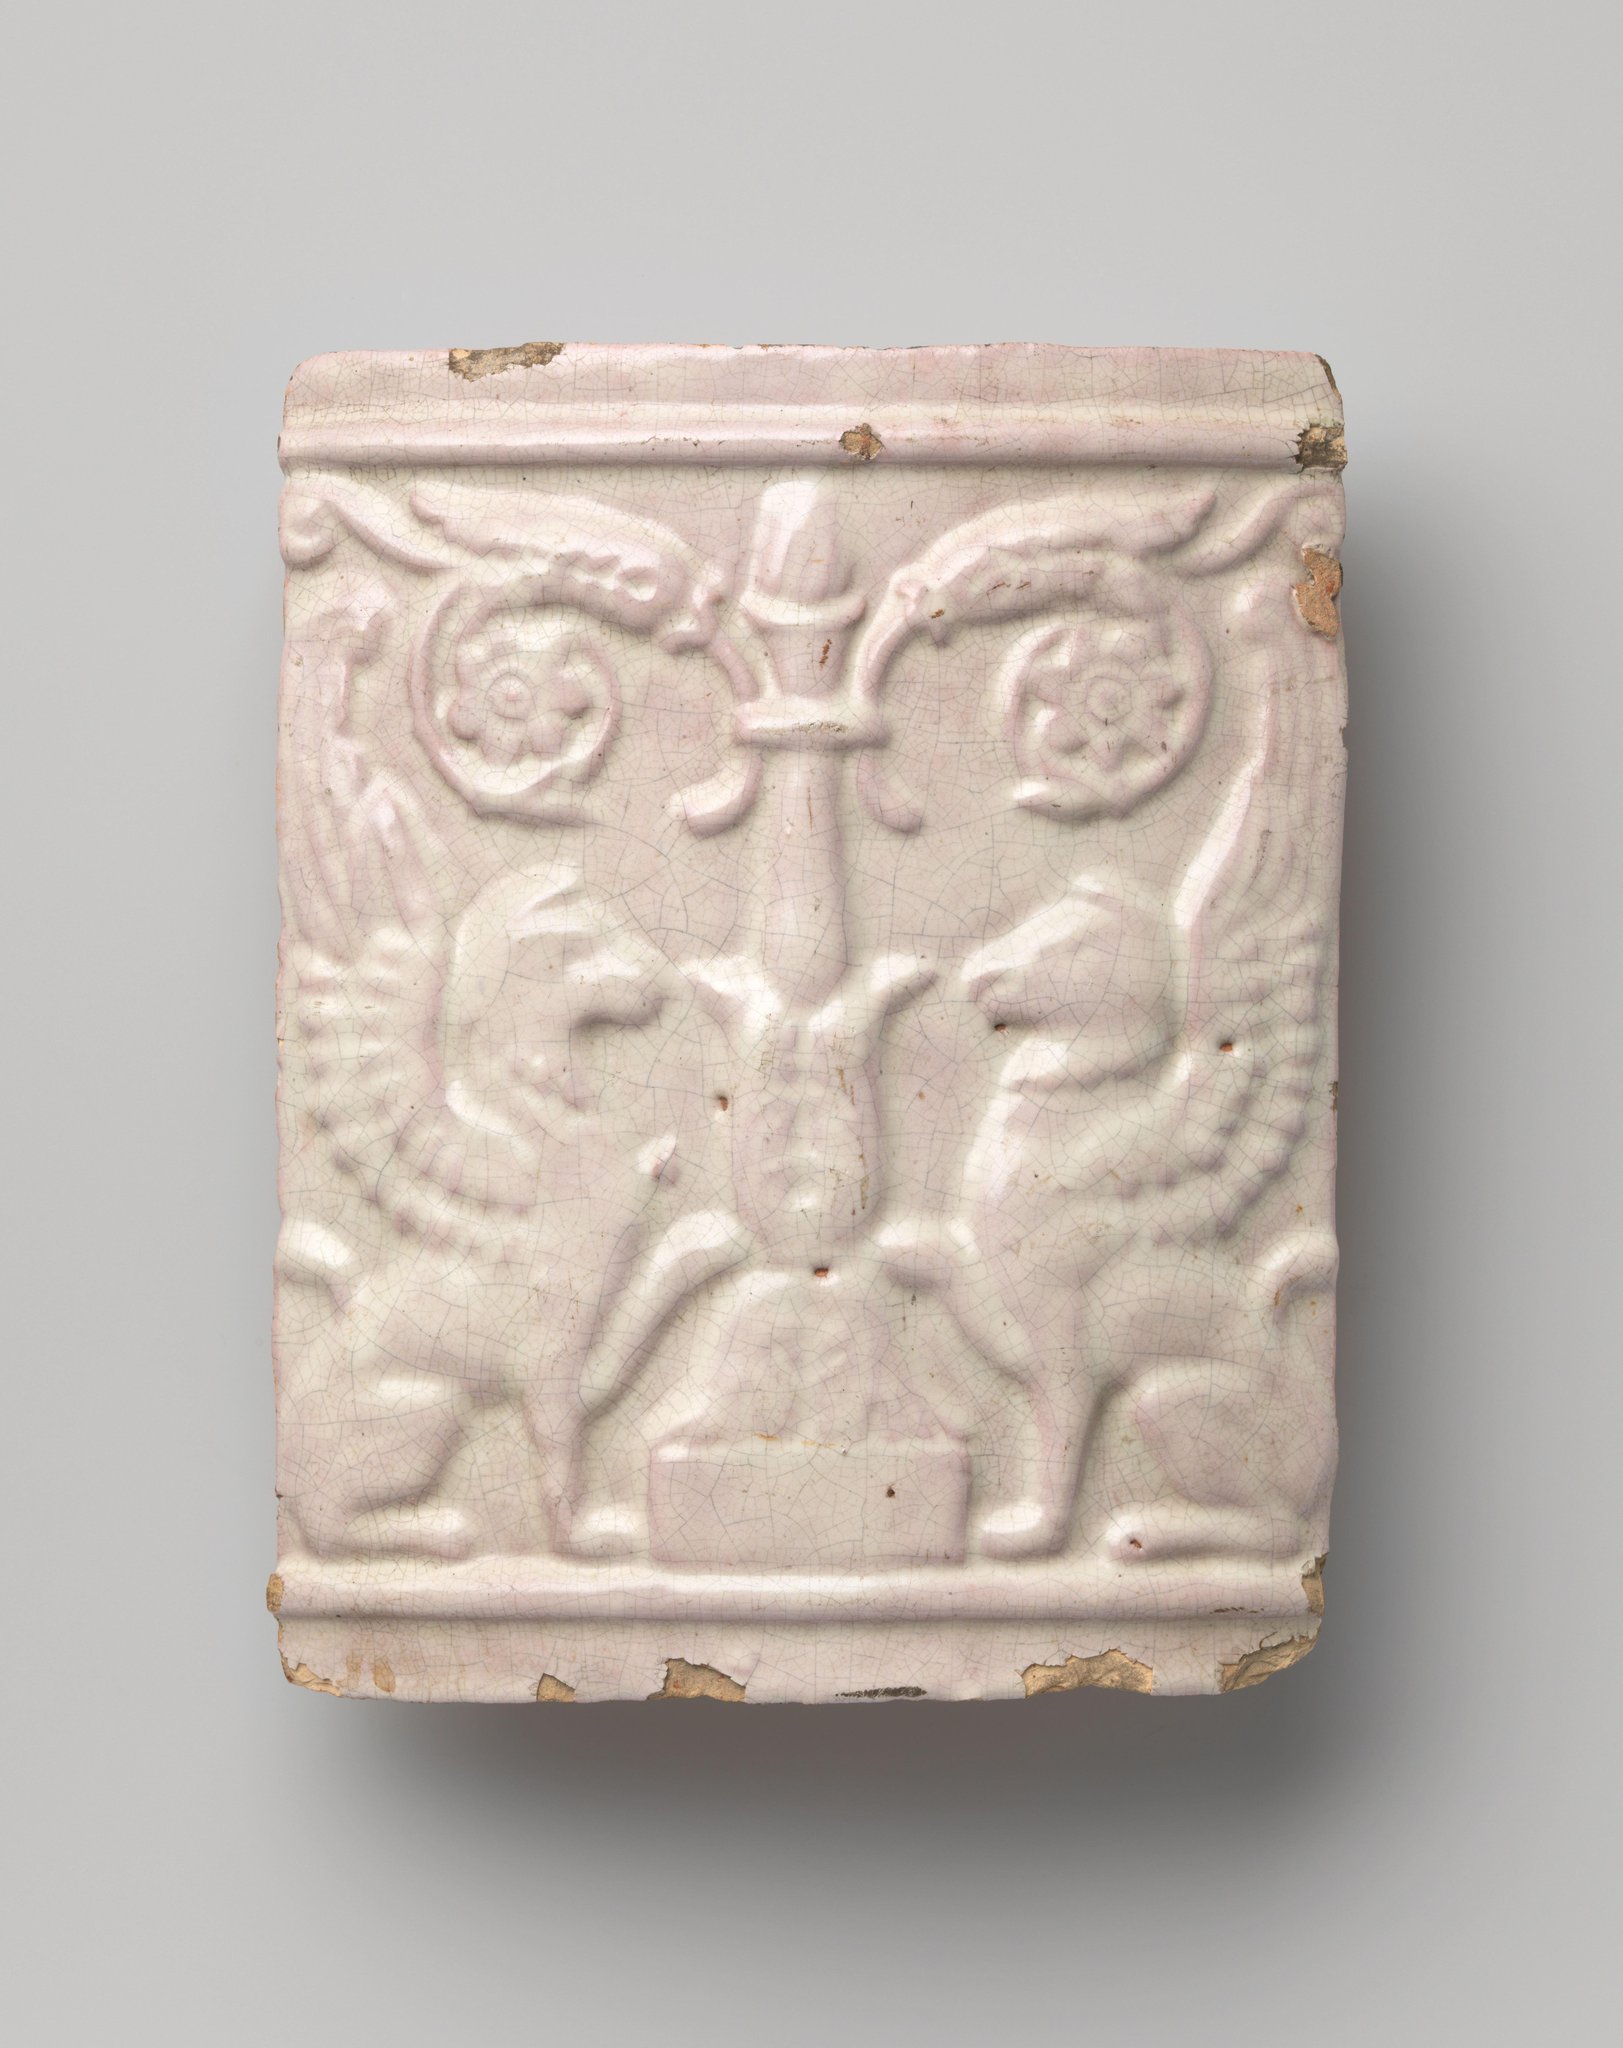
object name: kacheltegel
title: Kacheltegel versierd met griffioenen, kandelaber en bloemen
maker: Anonymous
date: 1850-1900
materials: earthenware, glaze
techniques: firing, relief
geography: zeist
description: Kacheltegel van rood aardewerk, bedekt met witte tinglazuur en versierd met griffioenen aan weerszijden van een kandelabermotief met bloemen. De versiering is in reliëf en gedeeltelijk paars gehoogd.